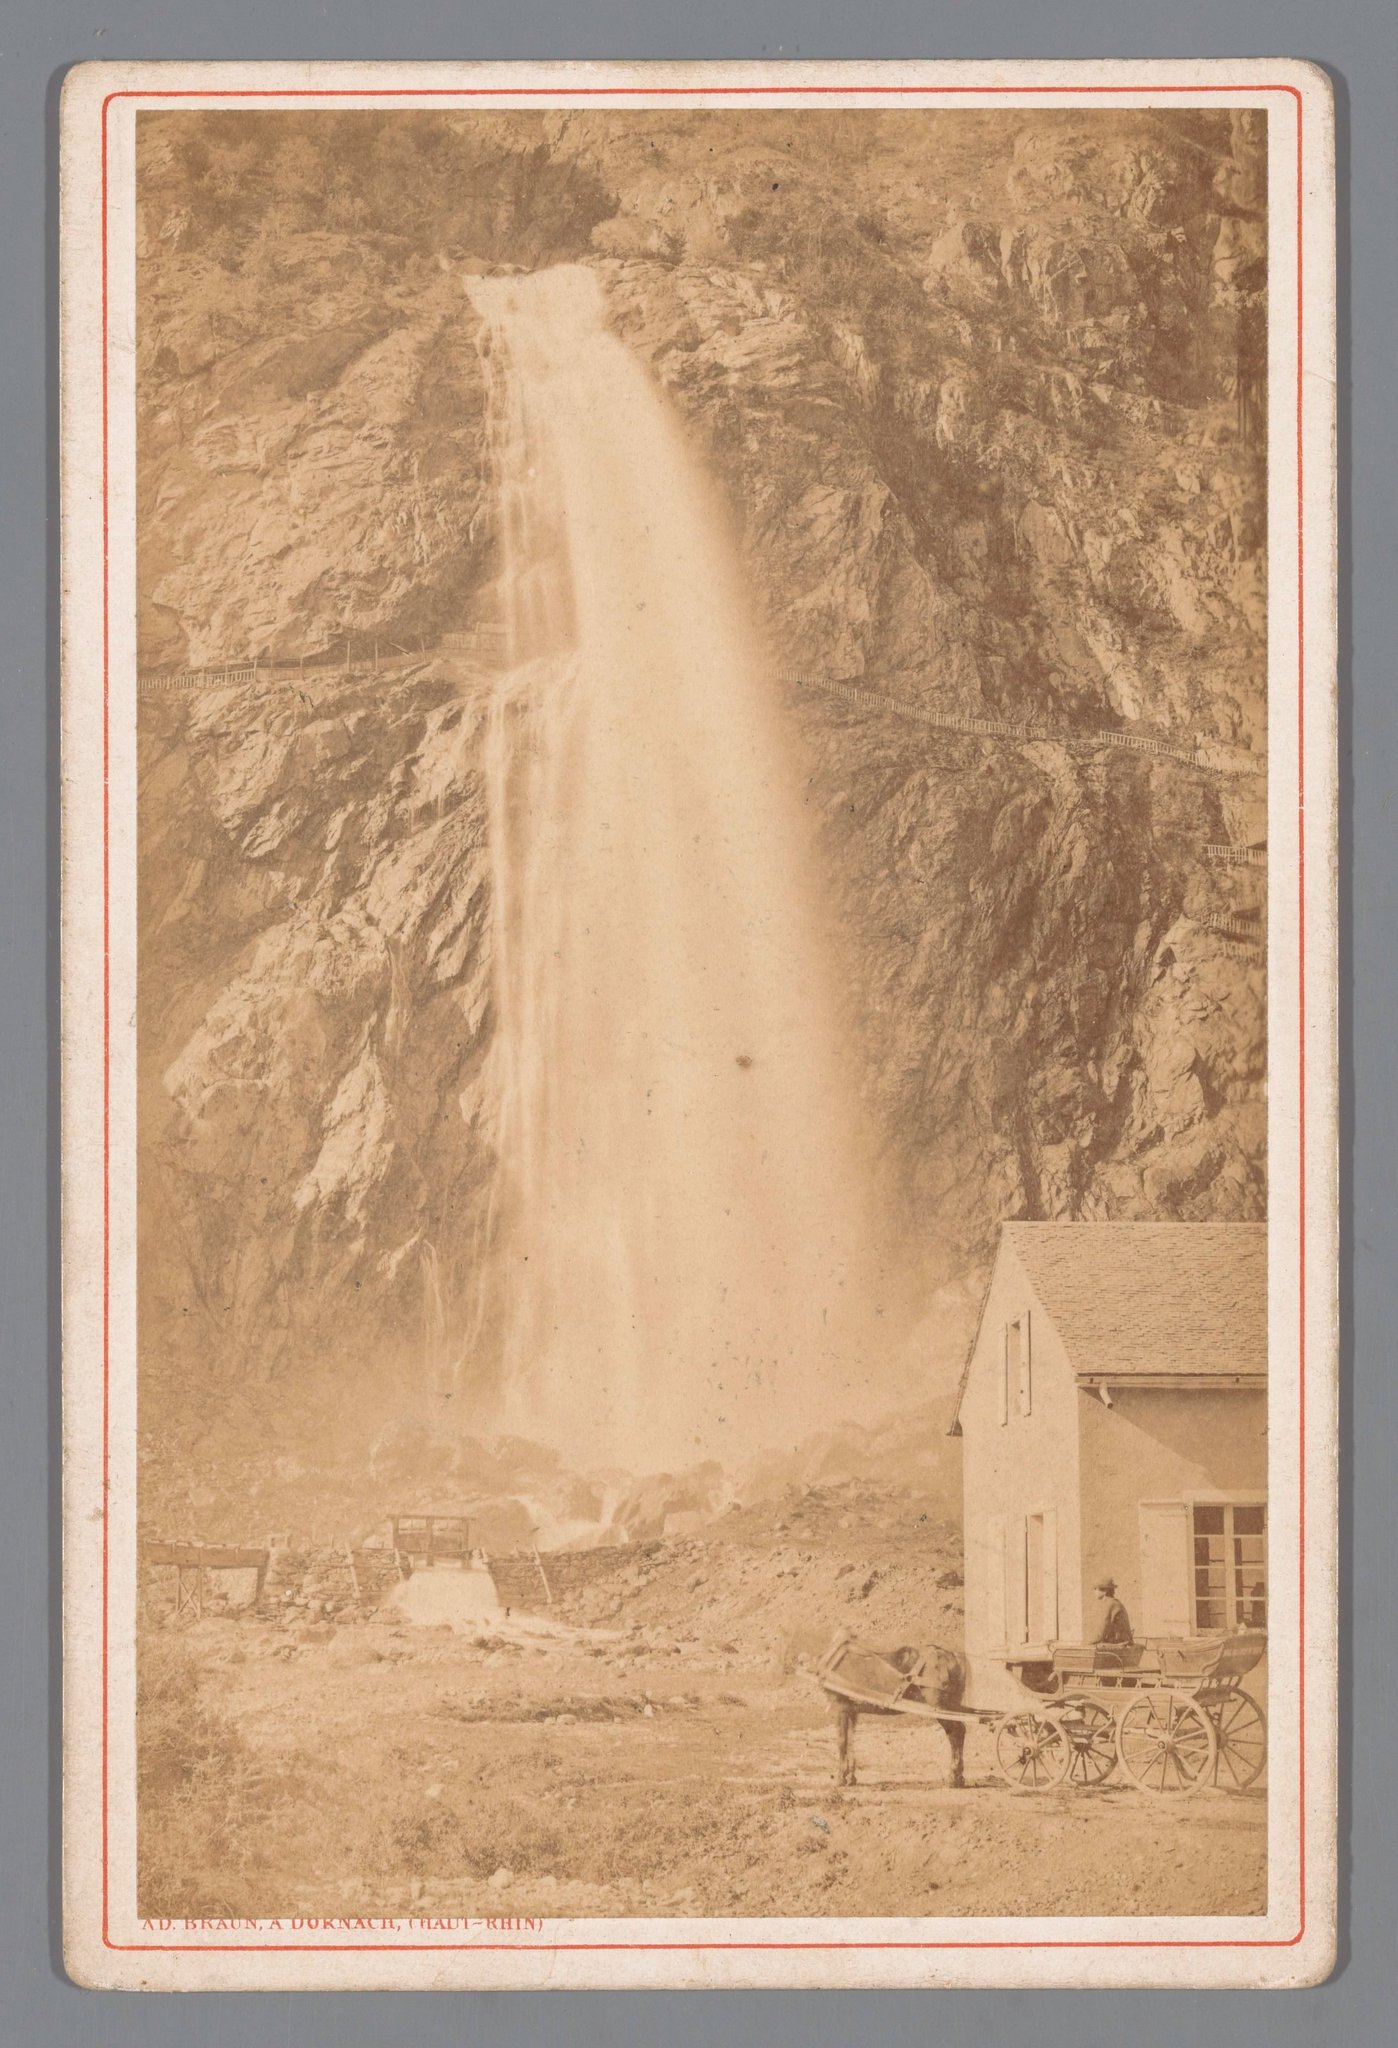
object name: photograph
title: Gezicht op de waterval Pissevache in Zwitserland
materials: cardboard, photographic support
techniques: albumen print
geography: switzerland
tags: waterfall, switzerland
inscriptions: number: ‘No. 420.’, annotation